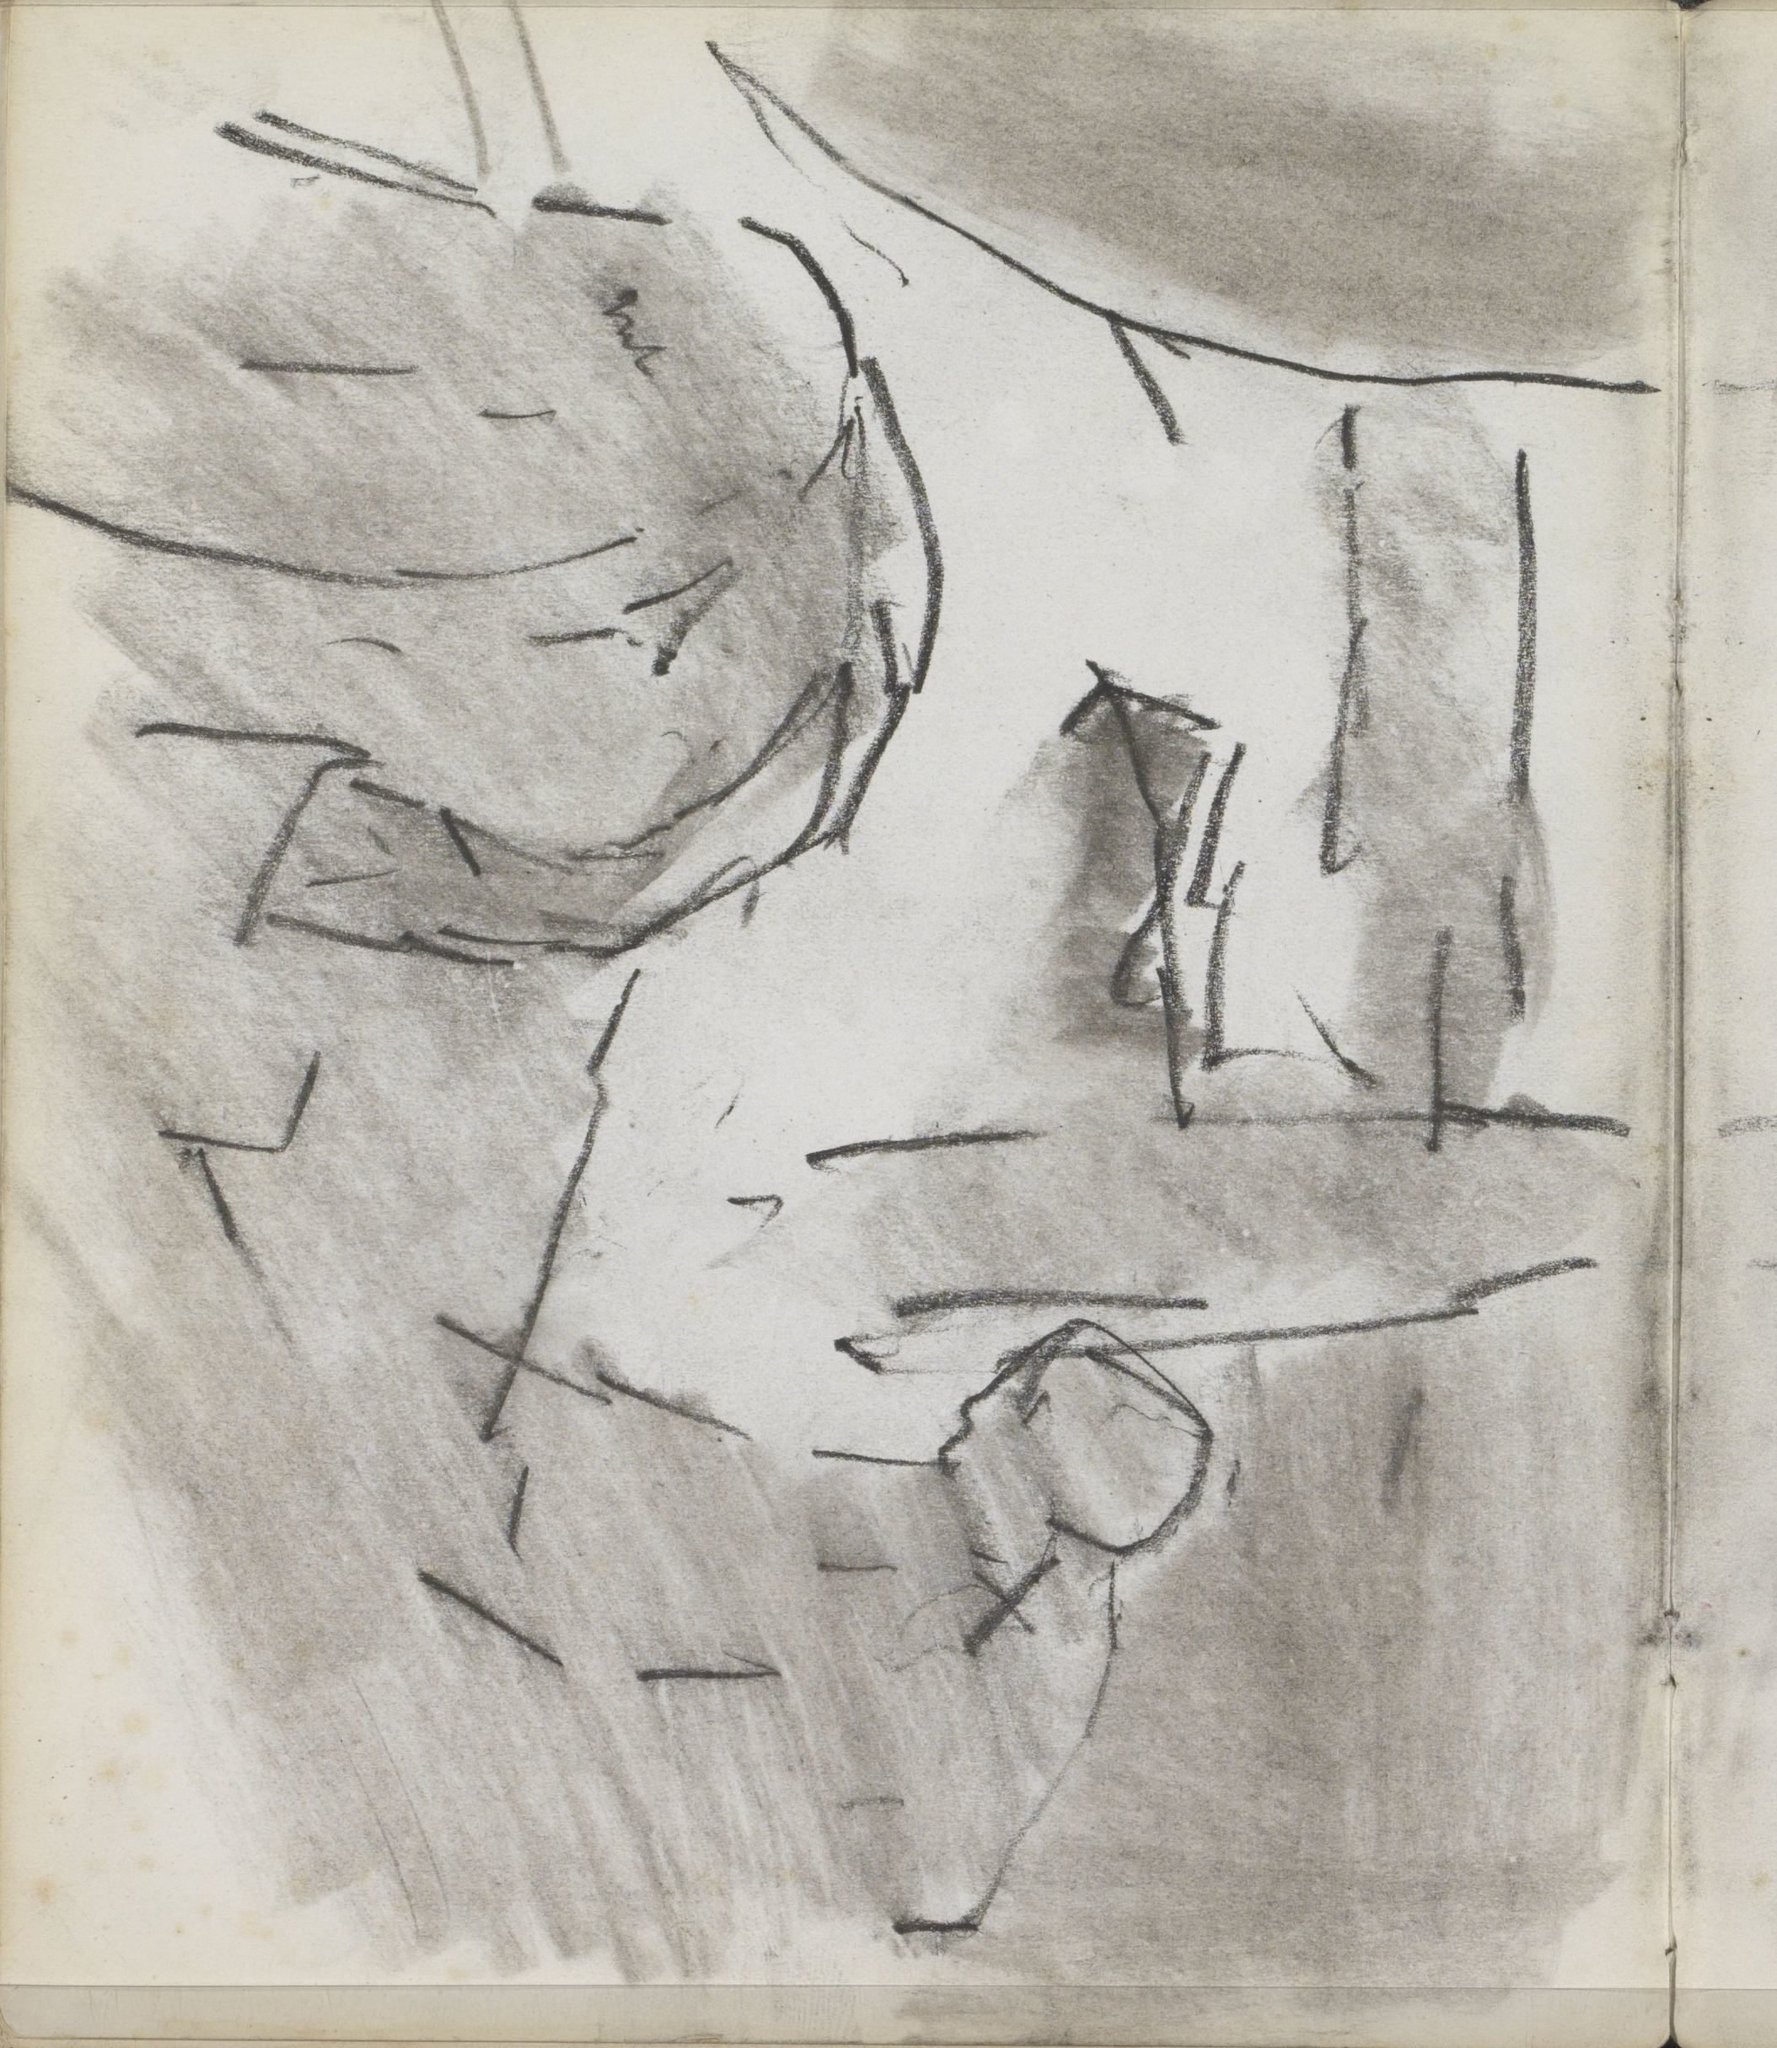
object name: sketchbook leaf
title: Bukkende vrouwen, mogelijk wasvrouwen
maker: george hendrik breitner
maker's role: draughtsman, painter, print maker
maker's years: 1857-1923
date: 1880-1906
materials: chalk, paper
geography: netherlands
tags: bending figure - aa - female human figure, laundering, adult woman (+ two persons)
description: Pagina 155 uit een schetsboek met 81 bladen.